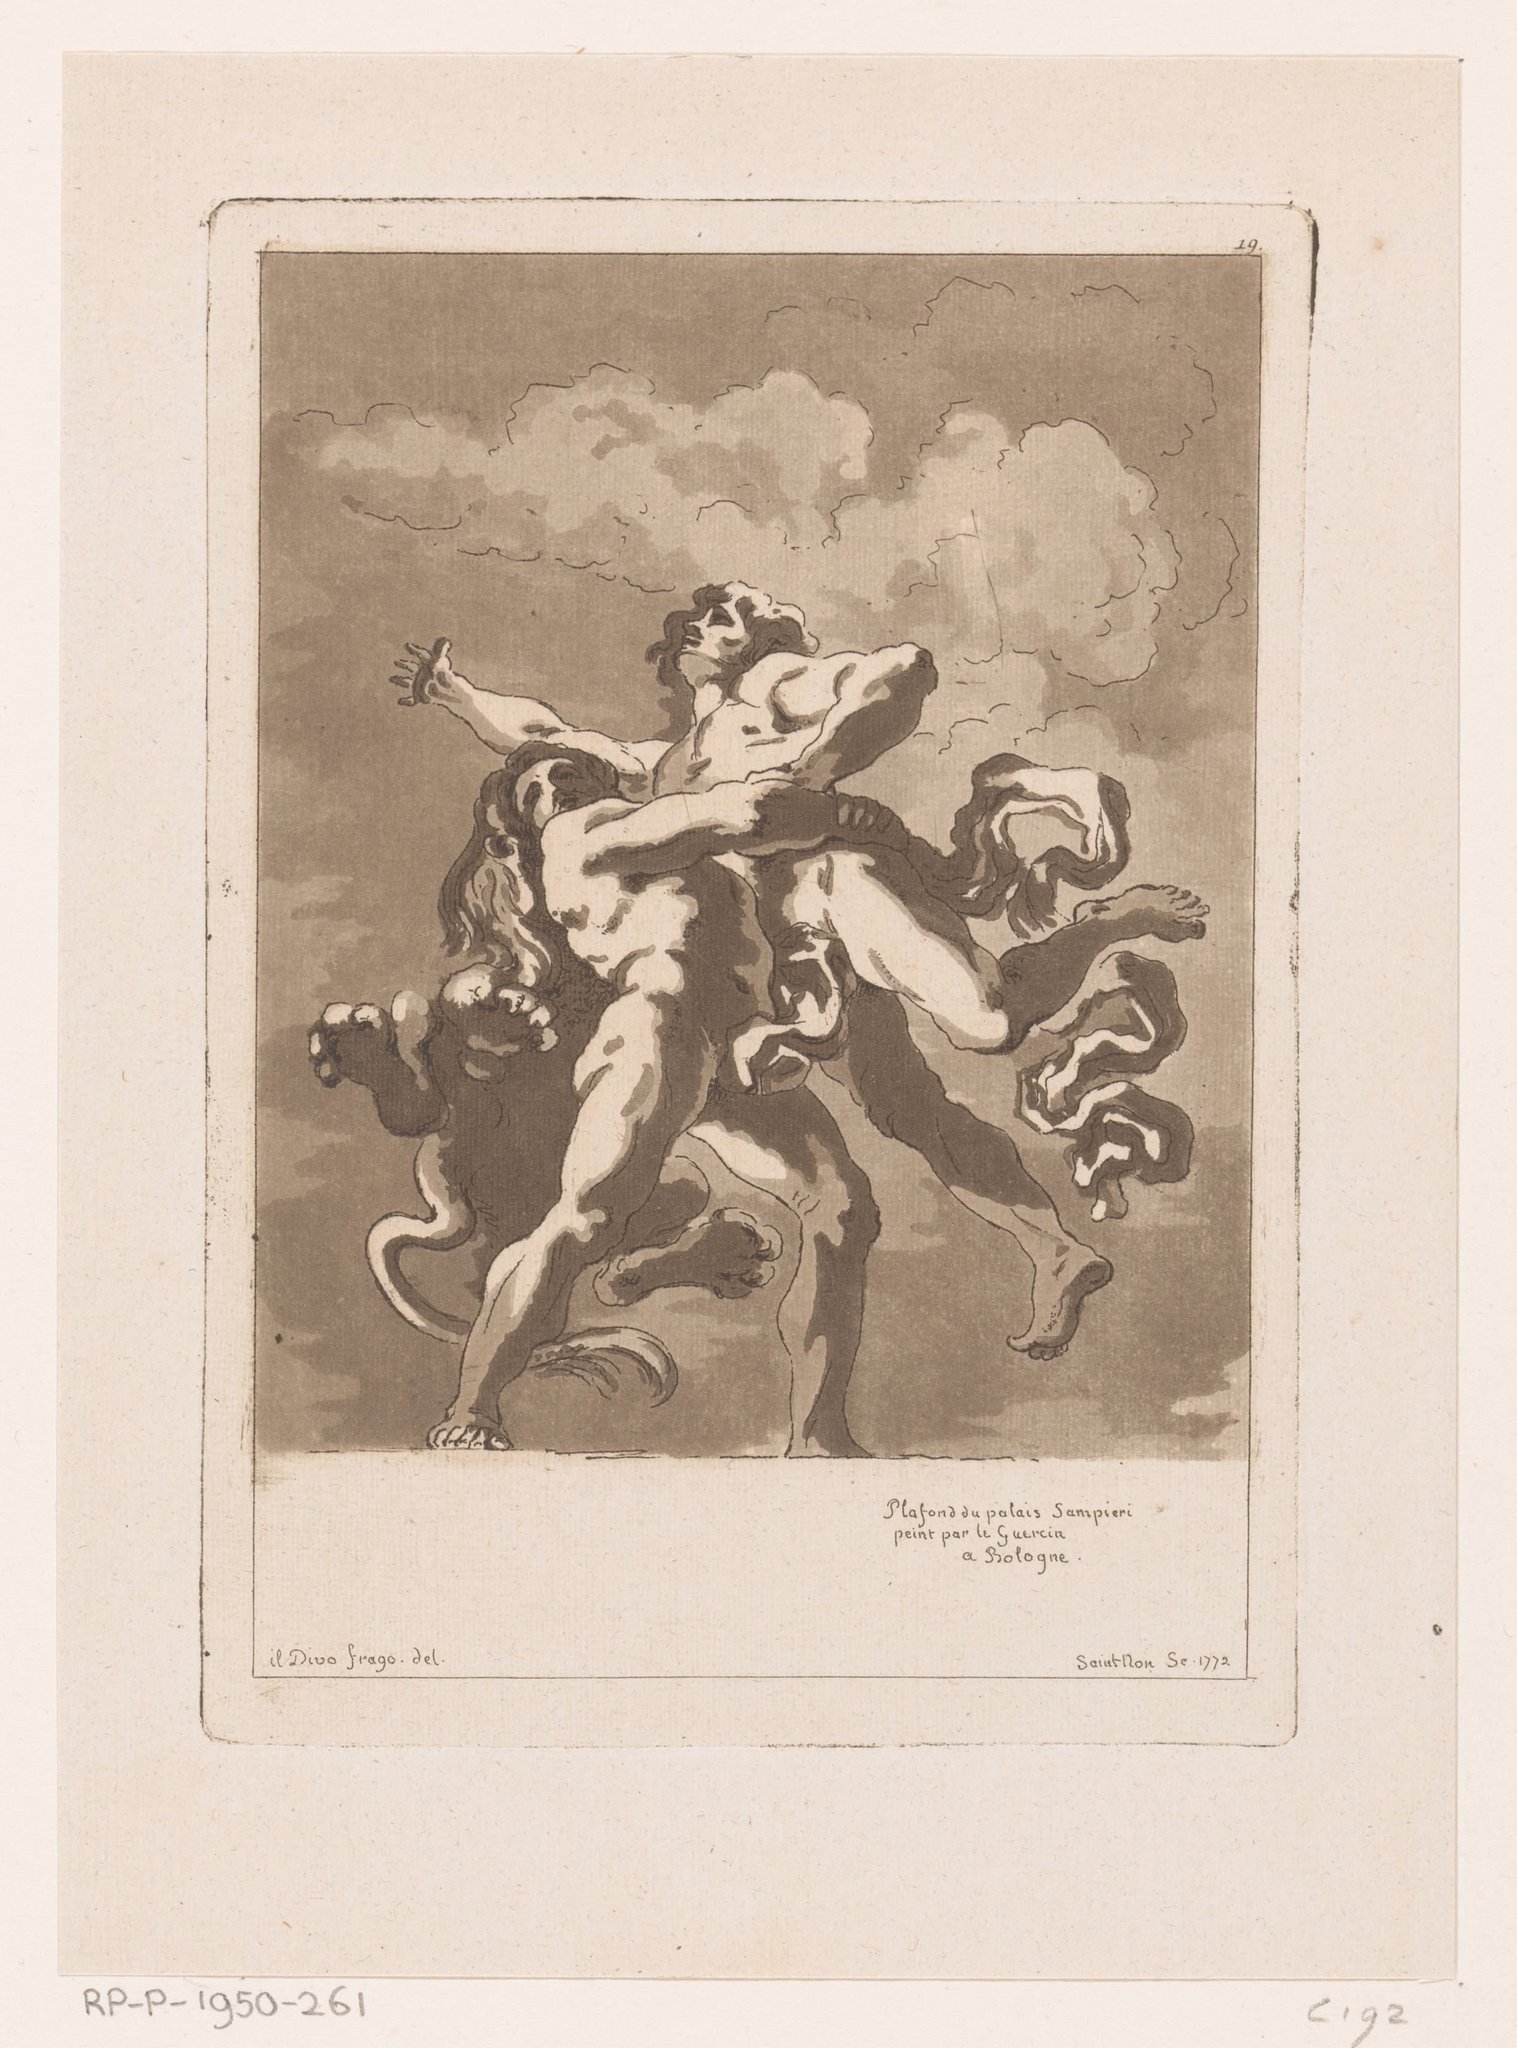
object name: print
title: Fragments choisis dans les peintures et les tableaux les plus intéressants de l'Italie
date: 1772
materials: paper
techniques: aquatint, etching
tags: the giant antaeus is lifted in the air and crushed to death by hercules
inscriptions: collector's mark: Lugt 2228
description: Prent maakt deel uit van een serie met daarbinnen delen over specifiek Rome, Bologna, Napels en Venetië.